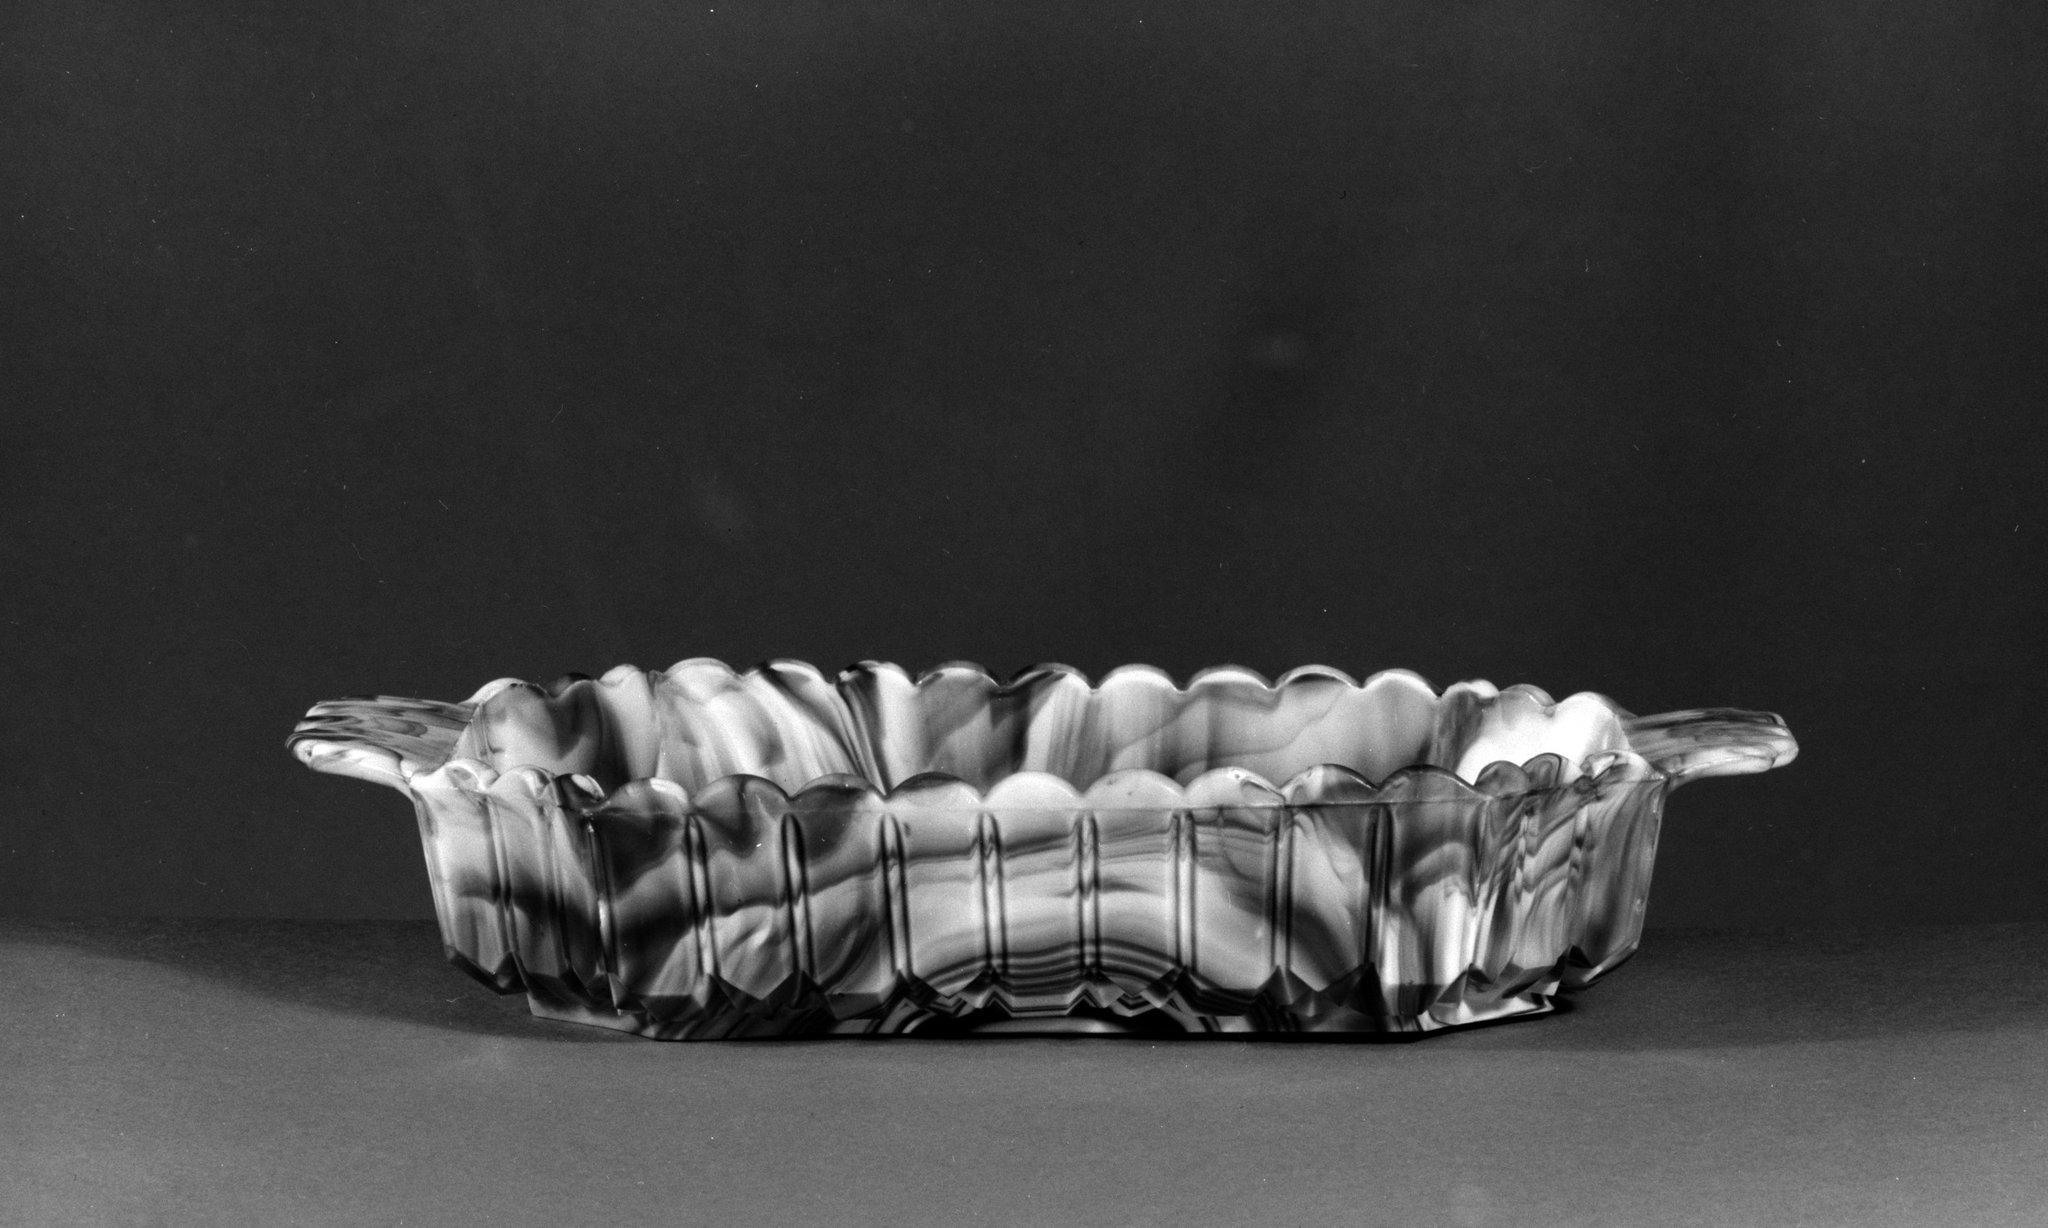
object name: dish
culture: american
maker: challinor, taylor and company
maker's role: maker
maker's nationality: american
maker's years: 1866-1891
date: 1870-1890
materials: glass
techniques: pressed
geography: united states